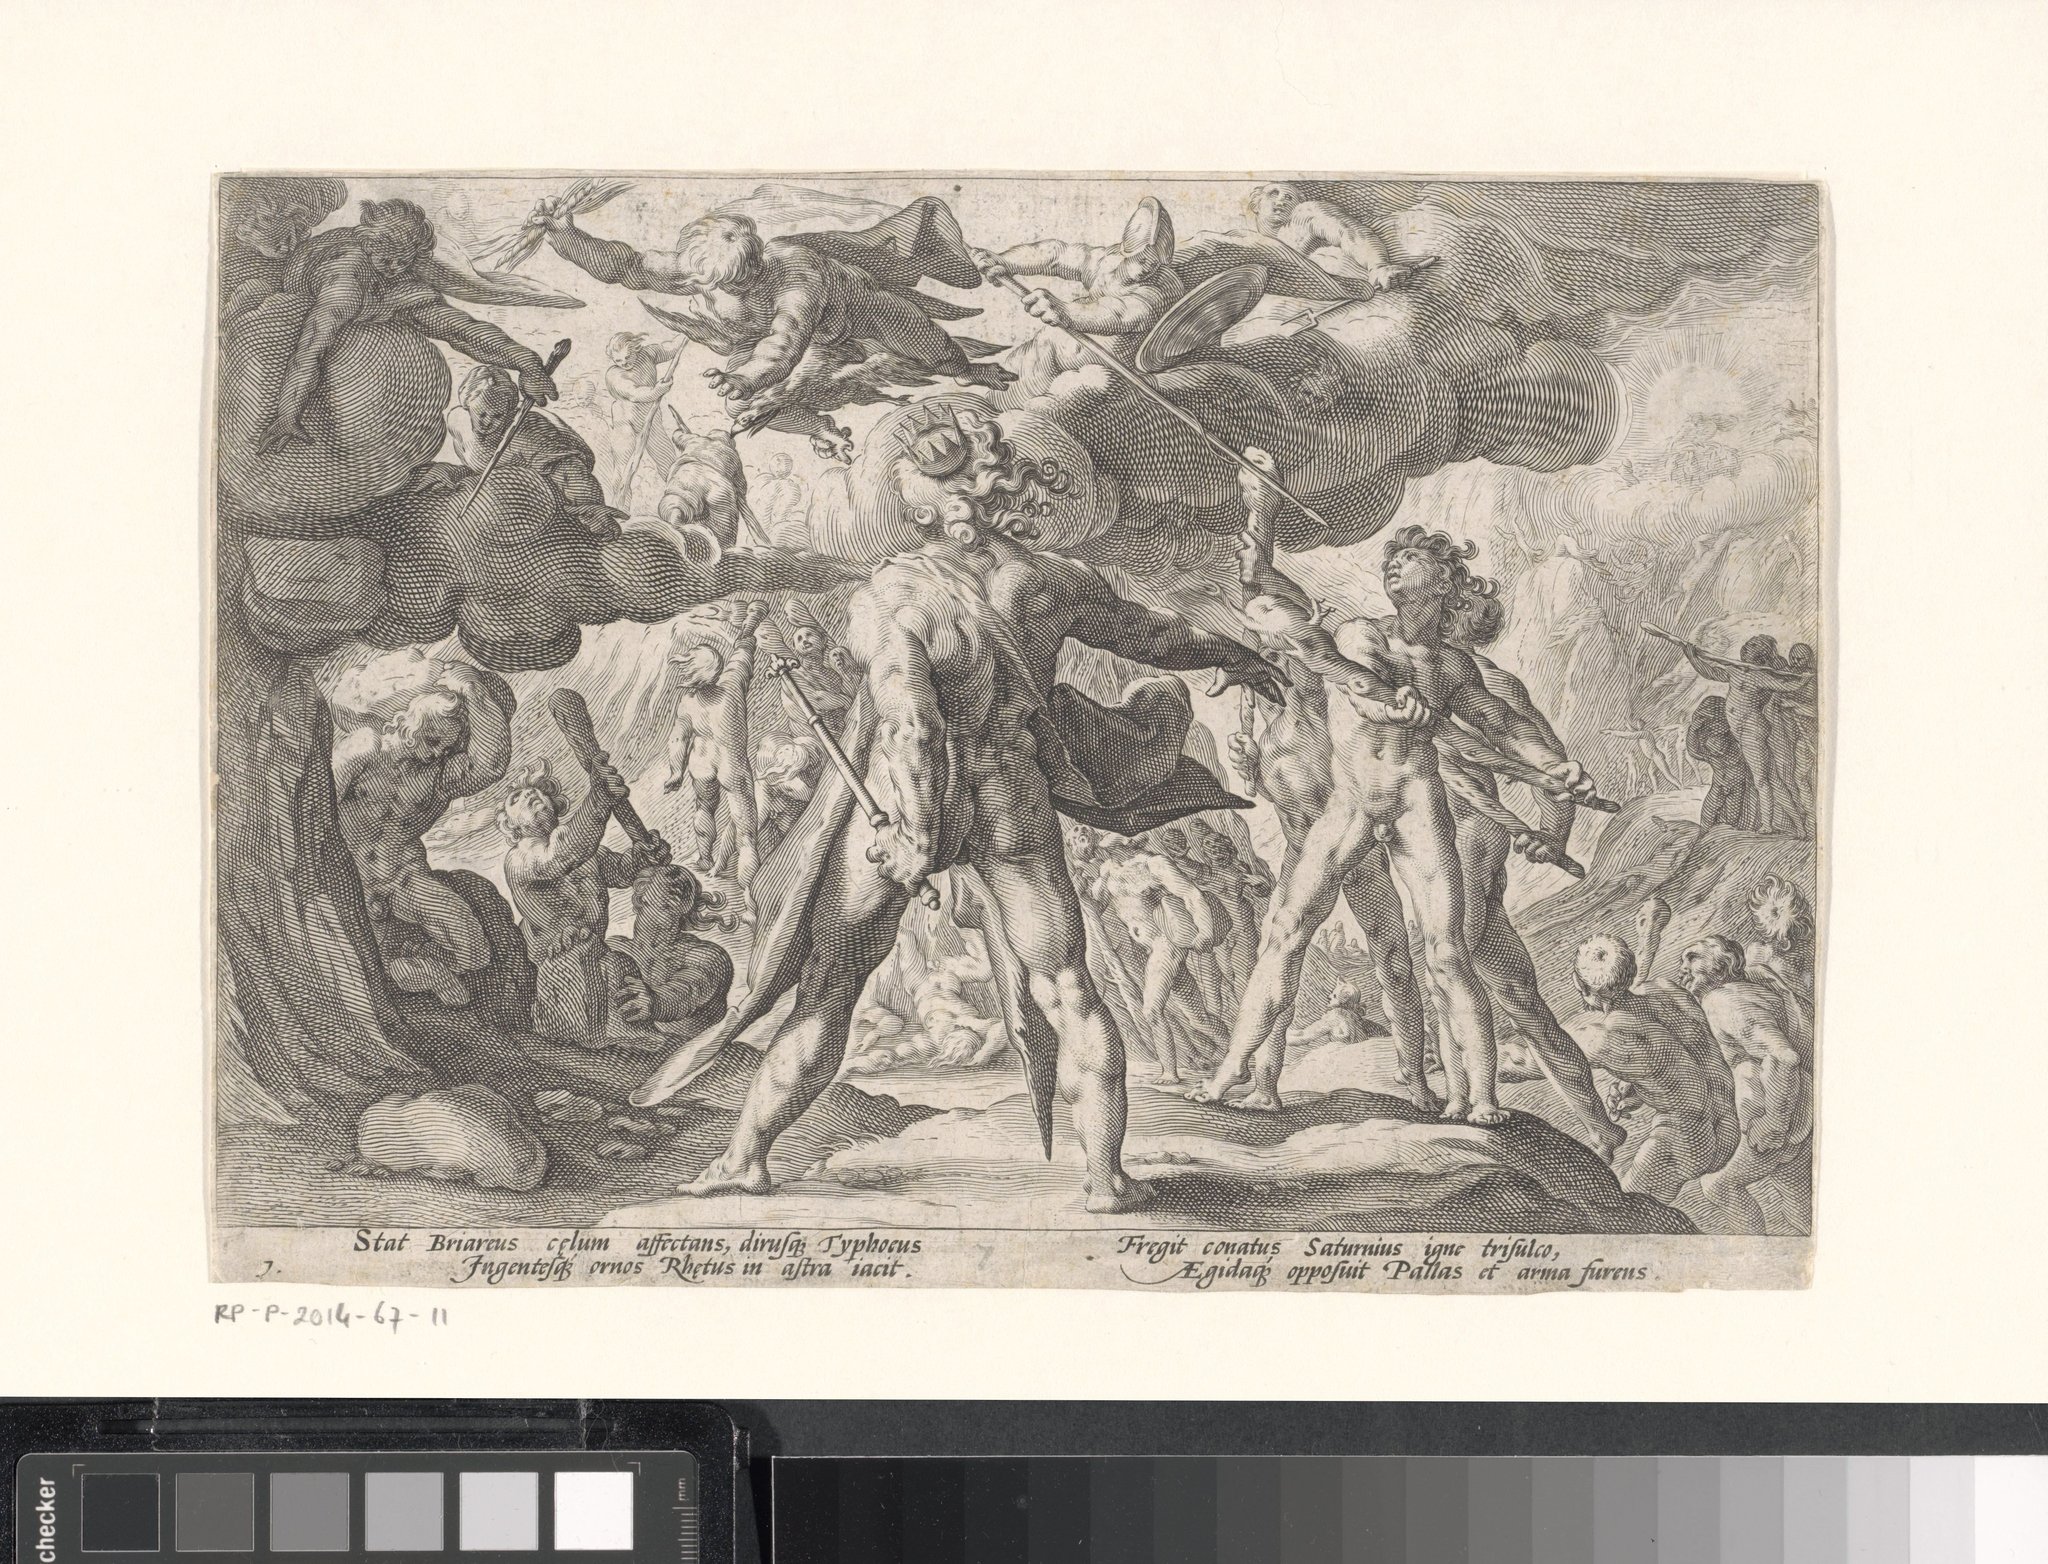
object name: print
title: Strijd tussen de goden en de giganten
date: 1589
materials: paper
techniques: engraving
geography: haarlem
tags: battle of the giants against the gods: gigantomachy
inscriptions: collector's mark: ‘Hinloopen’, collector's mark: Lugt 11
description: De giganten proberen vanaf de aarde via bergen en met knotsen de hemel te veroveren waar de Olympische goden huizen. De goden vechten terug met wapens als een speer, bliksem en drietand. In de ondermarge een vierregelige toelichting, in twee kolommen, in het Latijn.